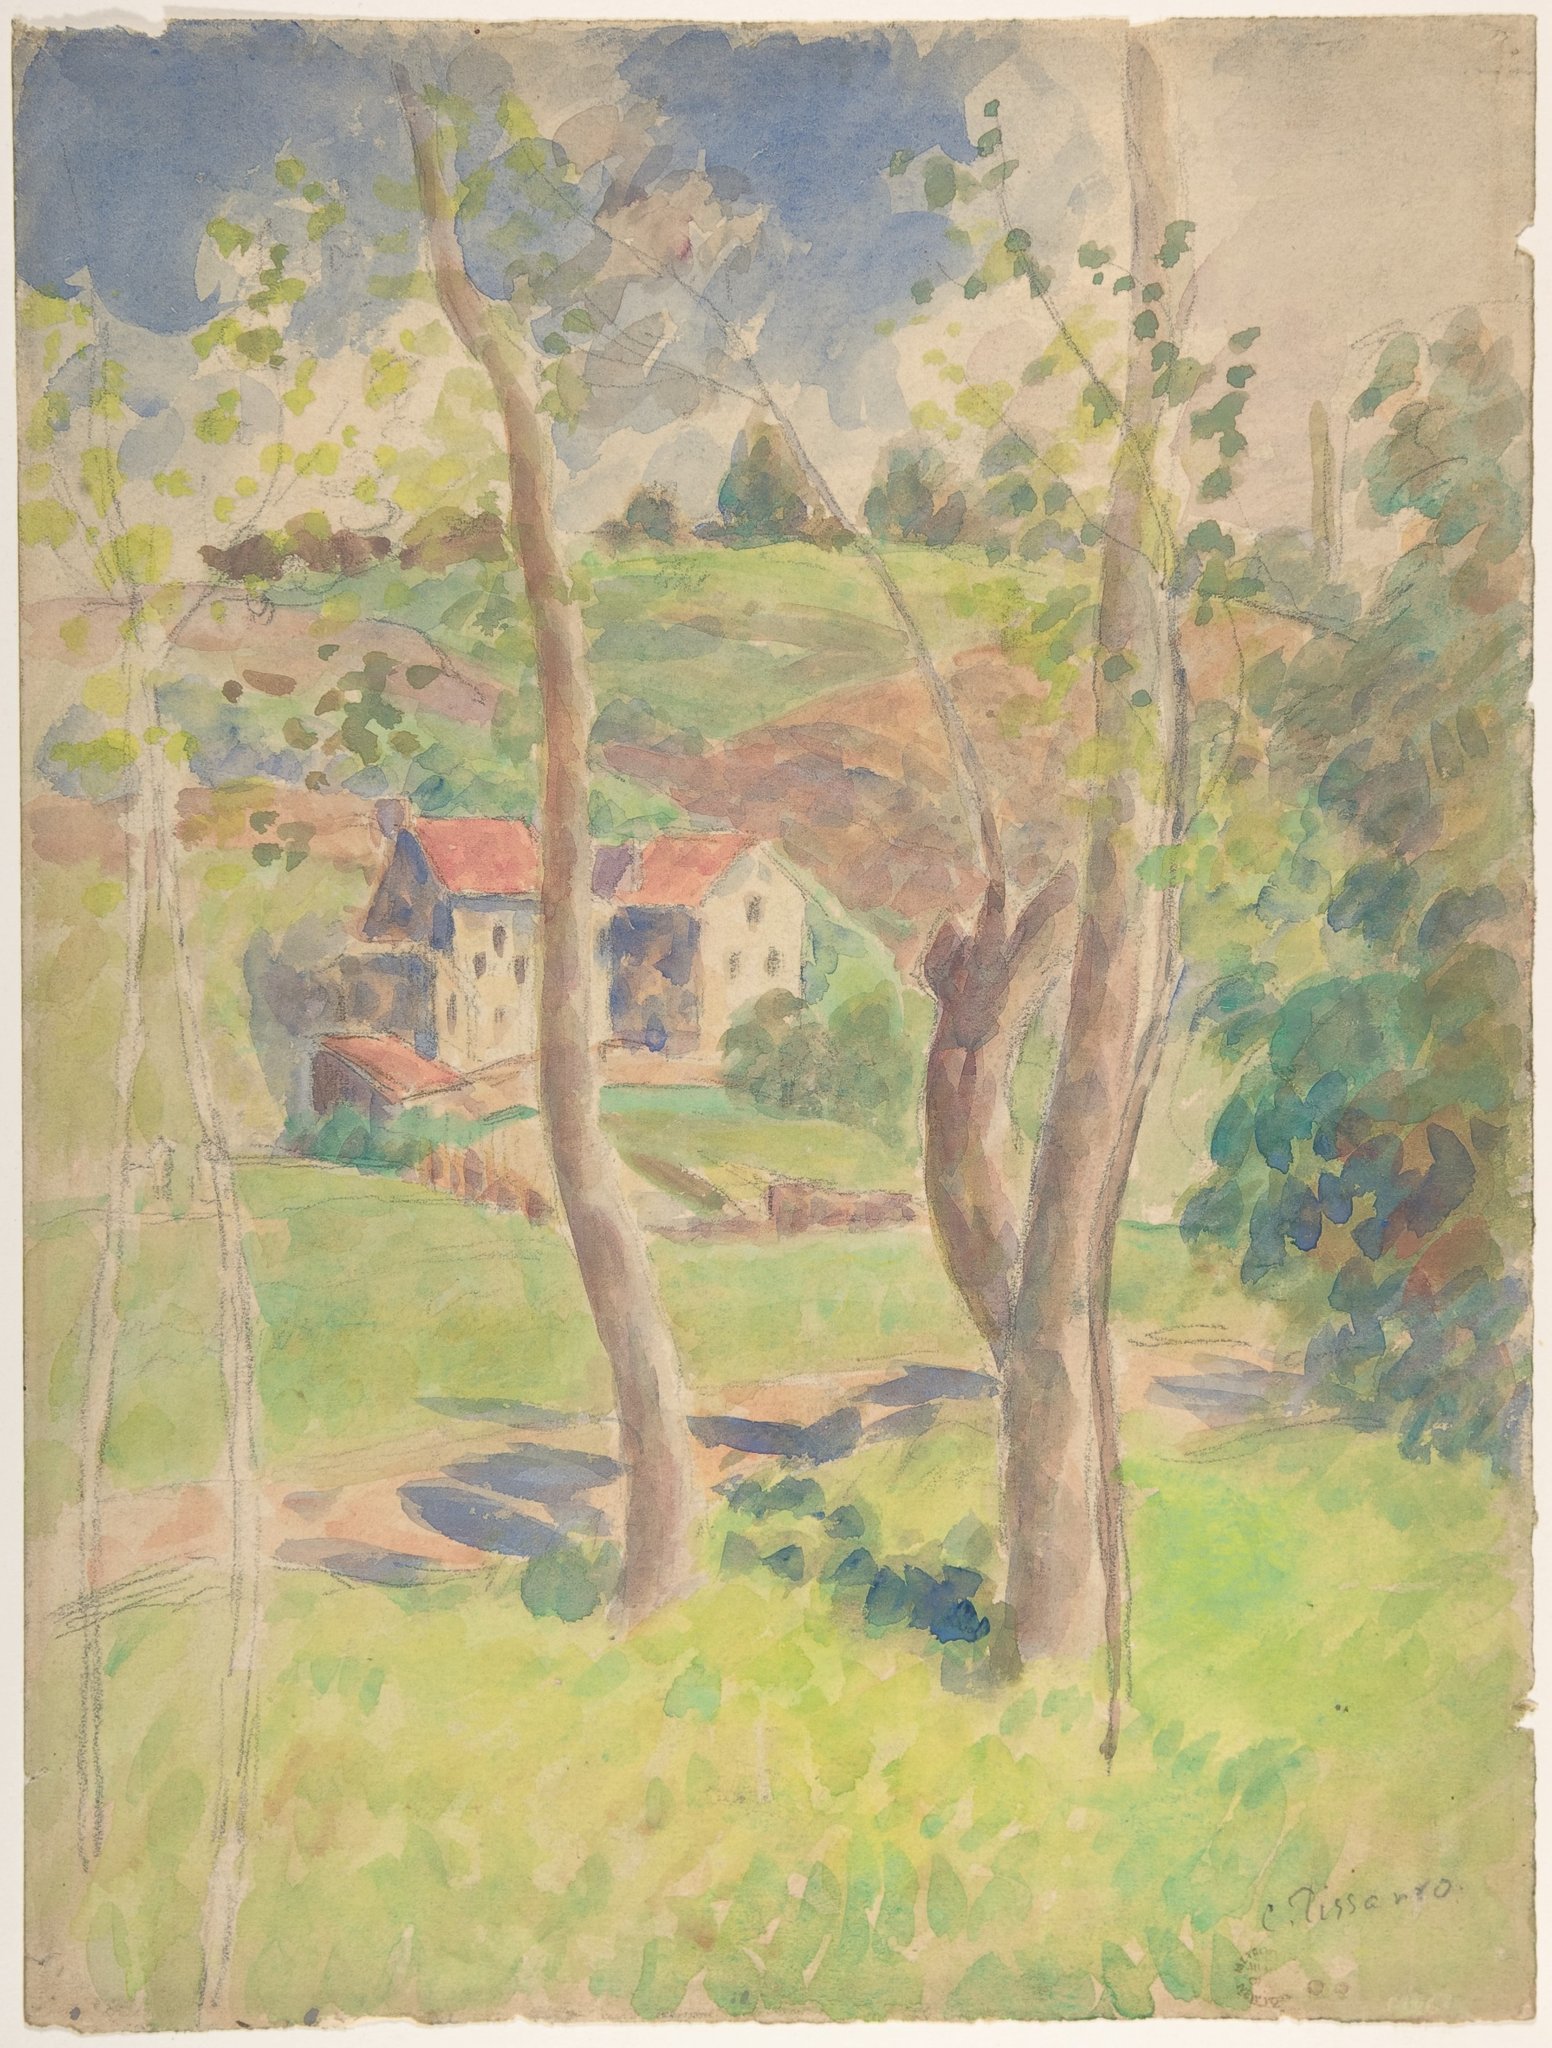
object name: drawing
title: Landscape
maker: camille pissarro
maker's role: artist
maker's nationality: french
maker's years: 1830-1903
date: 1851-1900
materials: chalk, watercolor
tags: houses,landscapes,trees